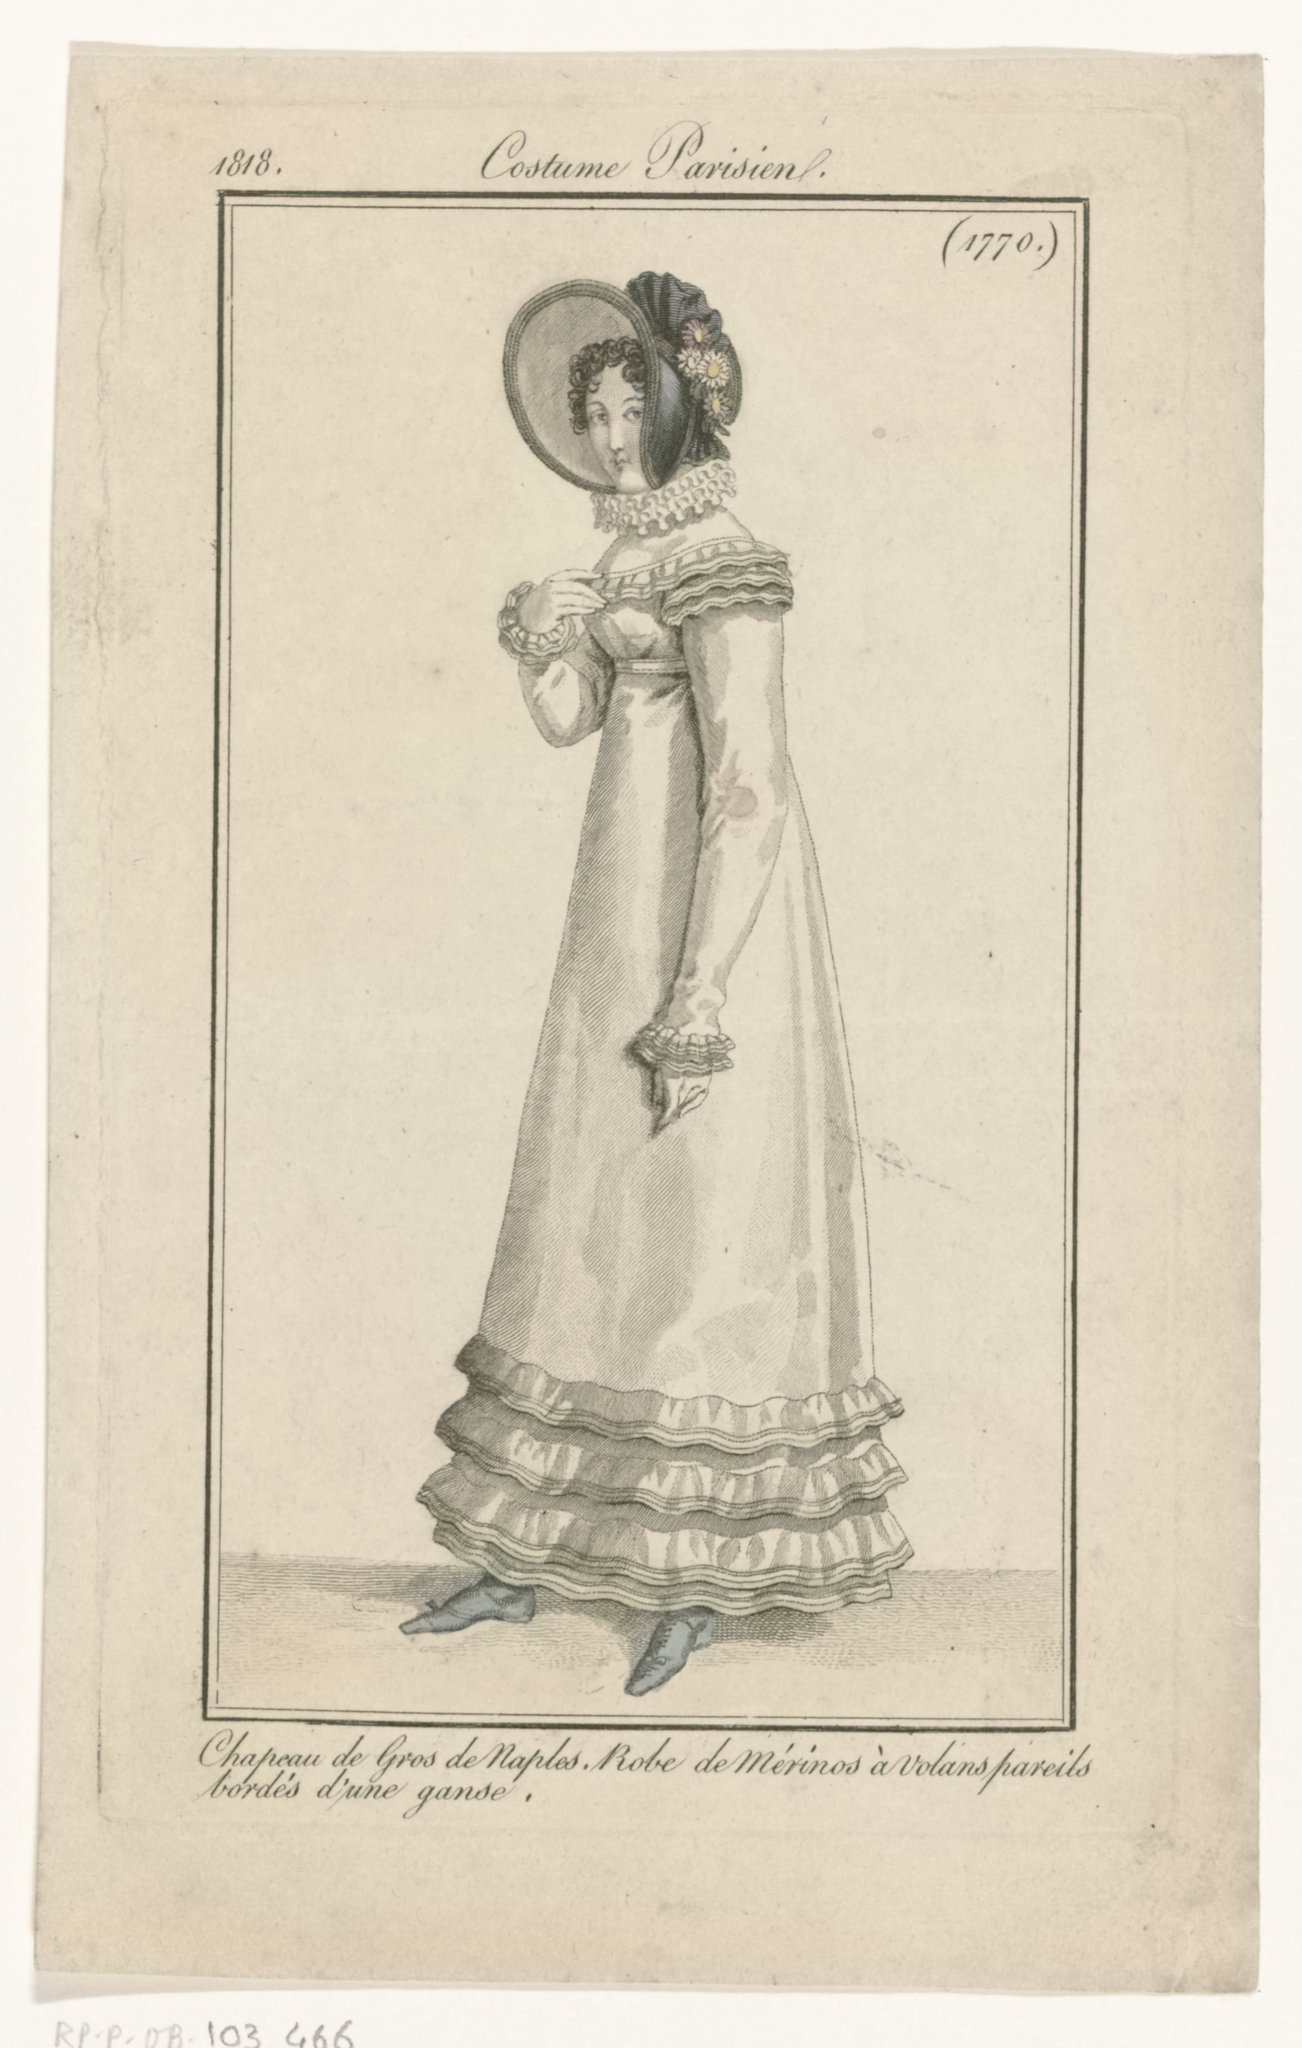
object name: fashion print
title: Journal des Dames et des Modes, Costume Parisien, 31 octobre 1818, (1770): Chapeau de Gros de Naples (...)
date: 1818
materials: paper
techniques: engraving, hand coloring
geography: paris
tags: fashion plates, head-gear: hat (+ women's clothes), neck-gear ~ clothing (with name) (+ women's clothes), dress, gown (+ women's clothes)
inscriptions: caption: ‘Chapeau de Gros de Naples. Robe de Mérinos à volans pareils bordés d'une ganse.’, title: ‘Costumes Parisiens.’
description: Staande vrouw gekleed in een japon van merinowol met bijpassende volants afgezet met een galon. Op het hoofd een luifelhoed van 'gros de Naples'. De prent maakt deel uit van het modetijdschrift Journal des Dames et des Modes, uitgegeven door Pierre de la Mésangère, Parijs, 1797-1839.